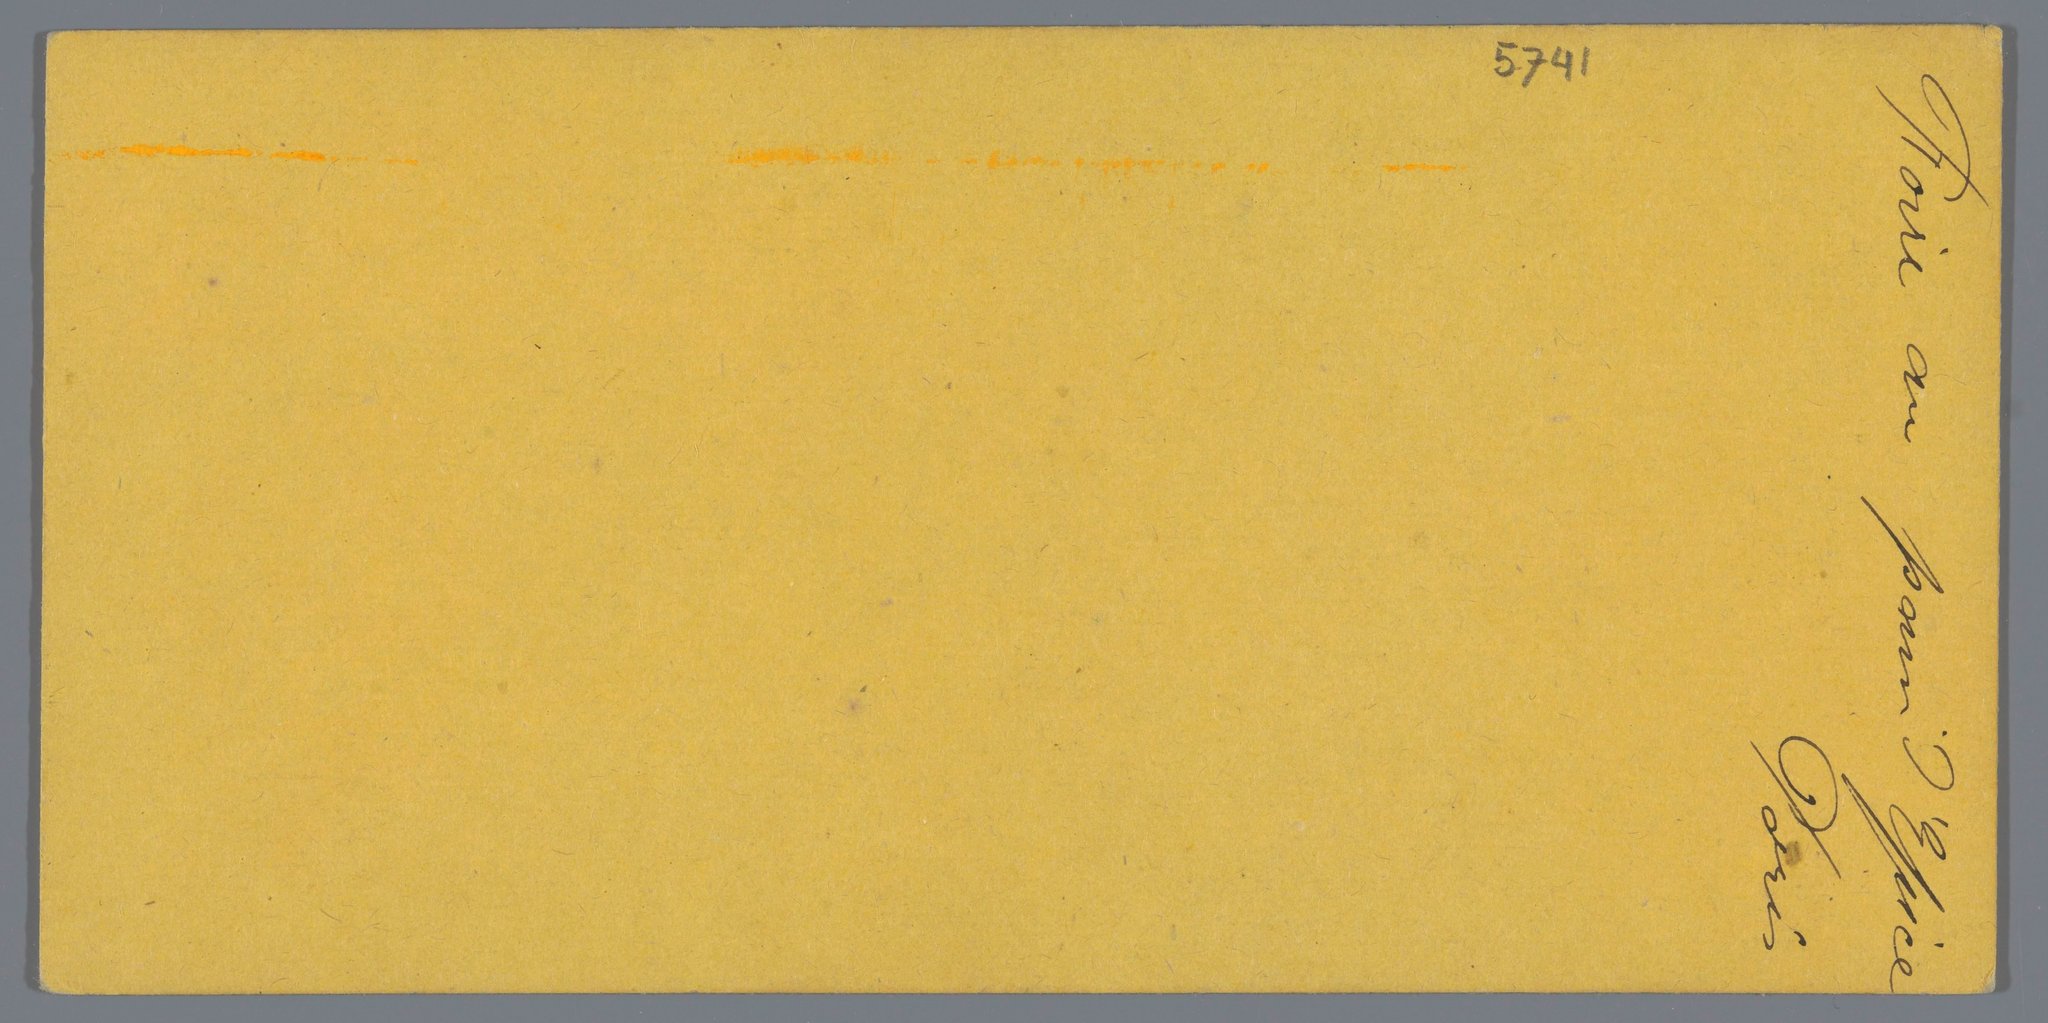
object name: stereograph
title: Gezicht op het feest Foire aux pains d’épices in Parijs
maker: Anonymous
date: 1850-1880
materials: cardboard, photographic support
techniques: albumen print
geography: paris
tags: pleasure fair and circus, paris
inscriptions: inscription: ‘Foire au pains d'Epice, Paris’